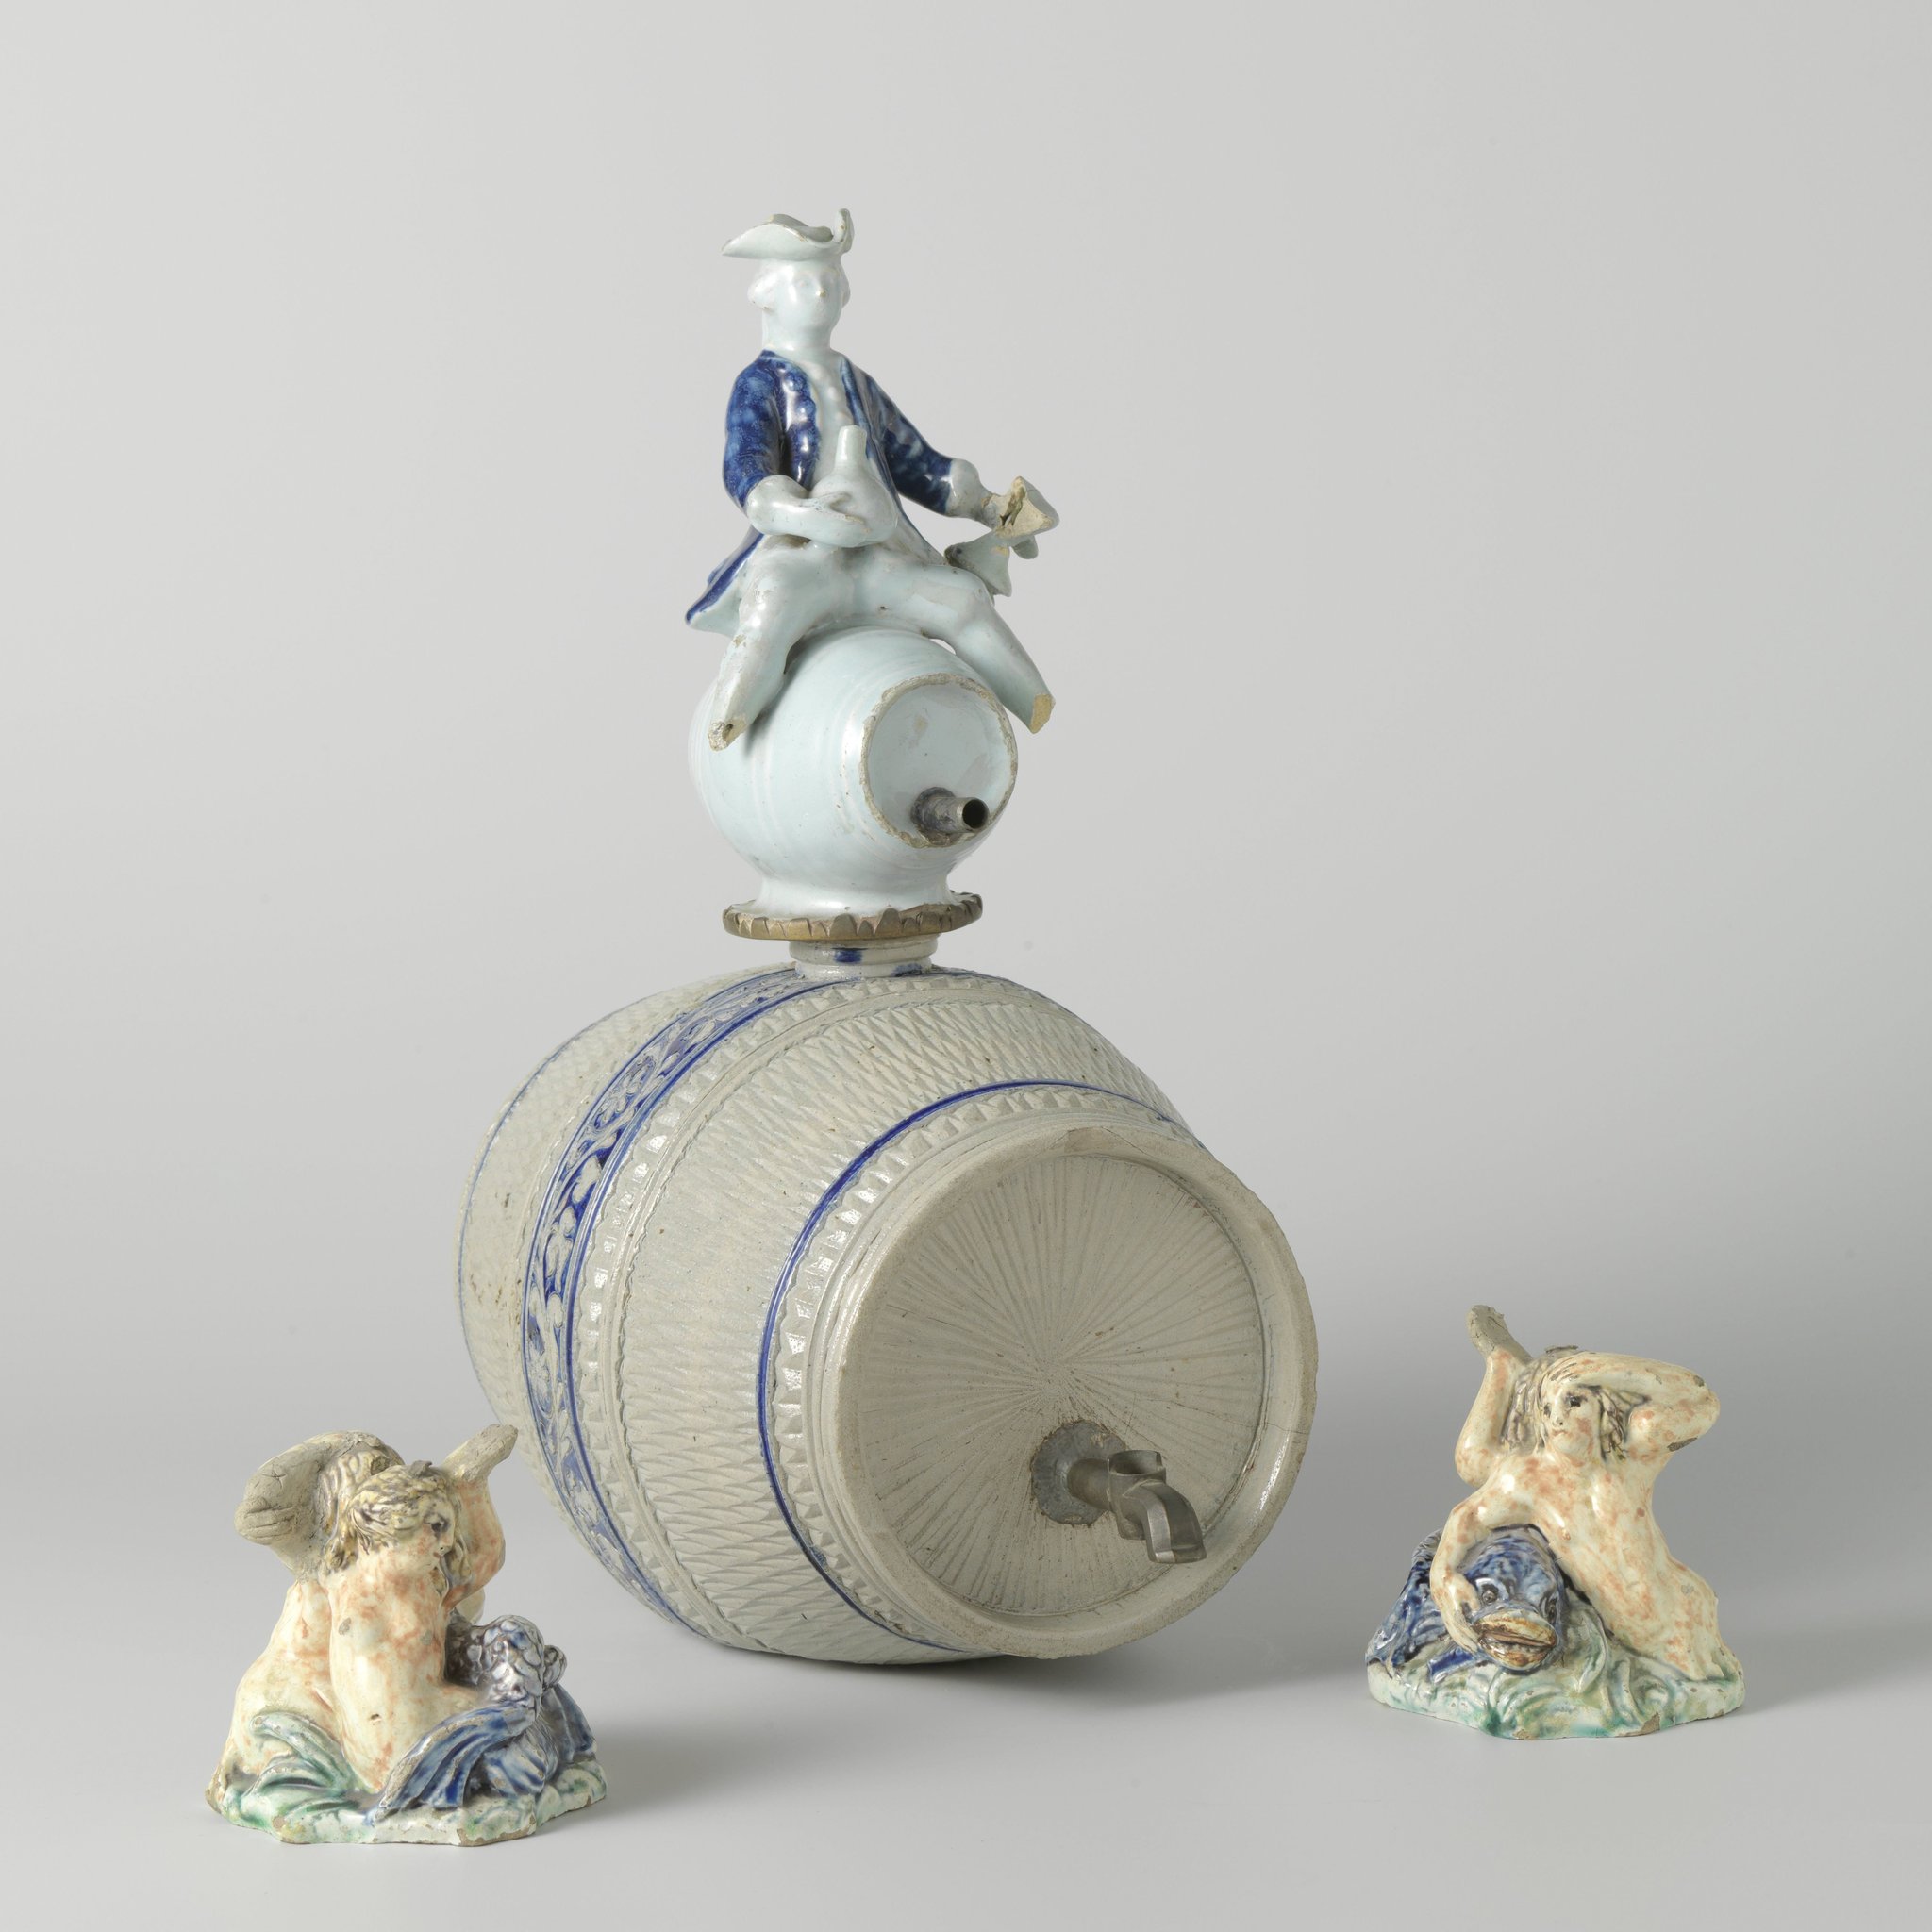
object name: steun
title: Steun in de vorm van een meermin en een meerman en een dolfijn op golven, behorend bij meiwijnvat van steengoed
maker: Anonymous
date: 1675-1750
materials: earthenware, glaze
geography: westerwald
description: Steun in de vorm van een meermin en een meerman en een dolfijn op golven, behorend bij meiwijnvat van steengoed met tinnen tap.